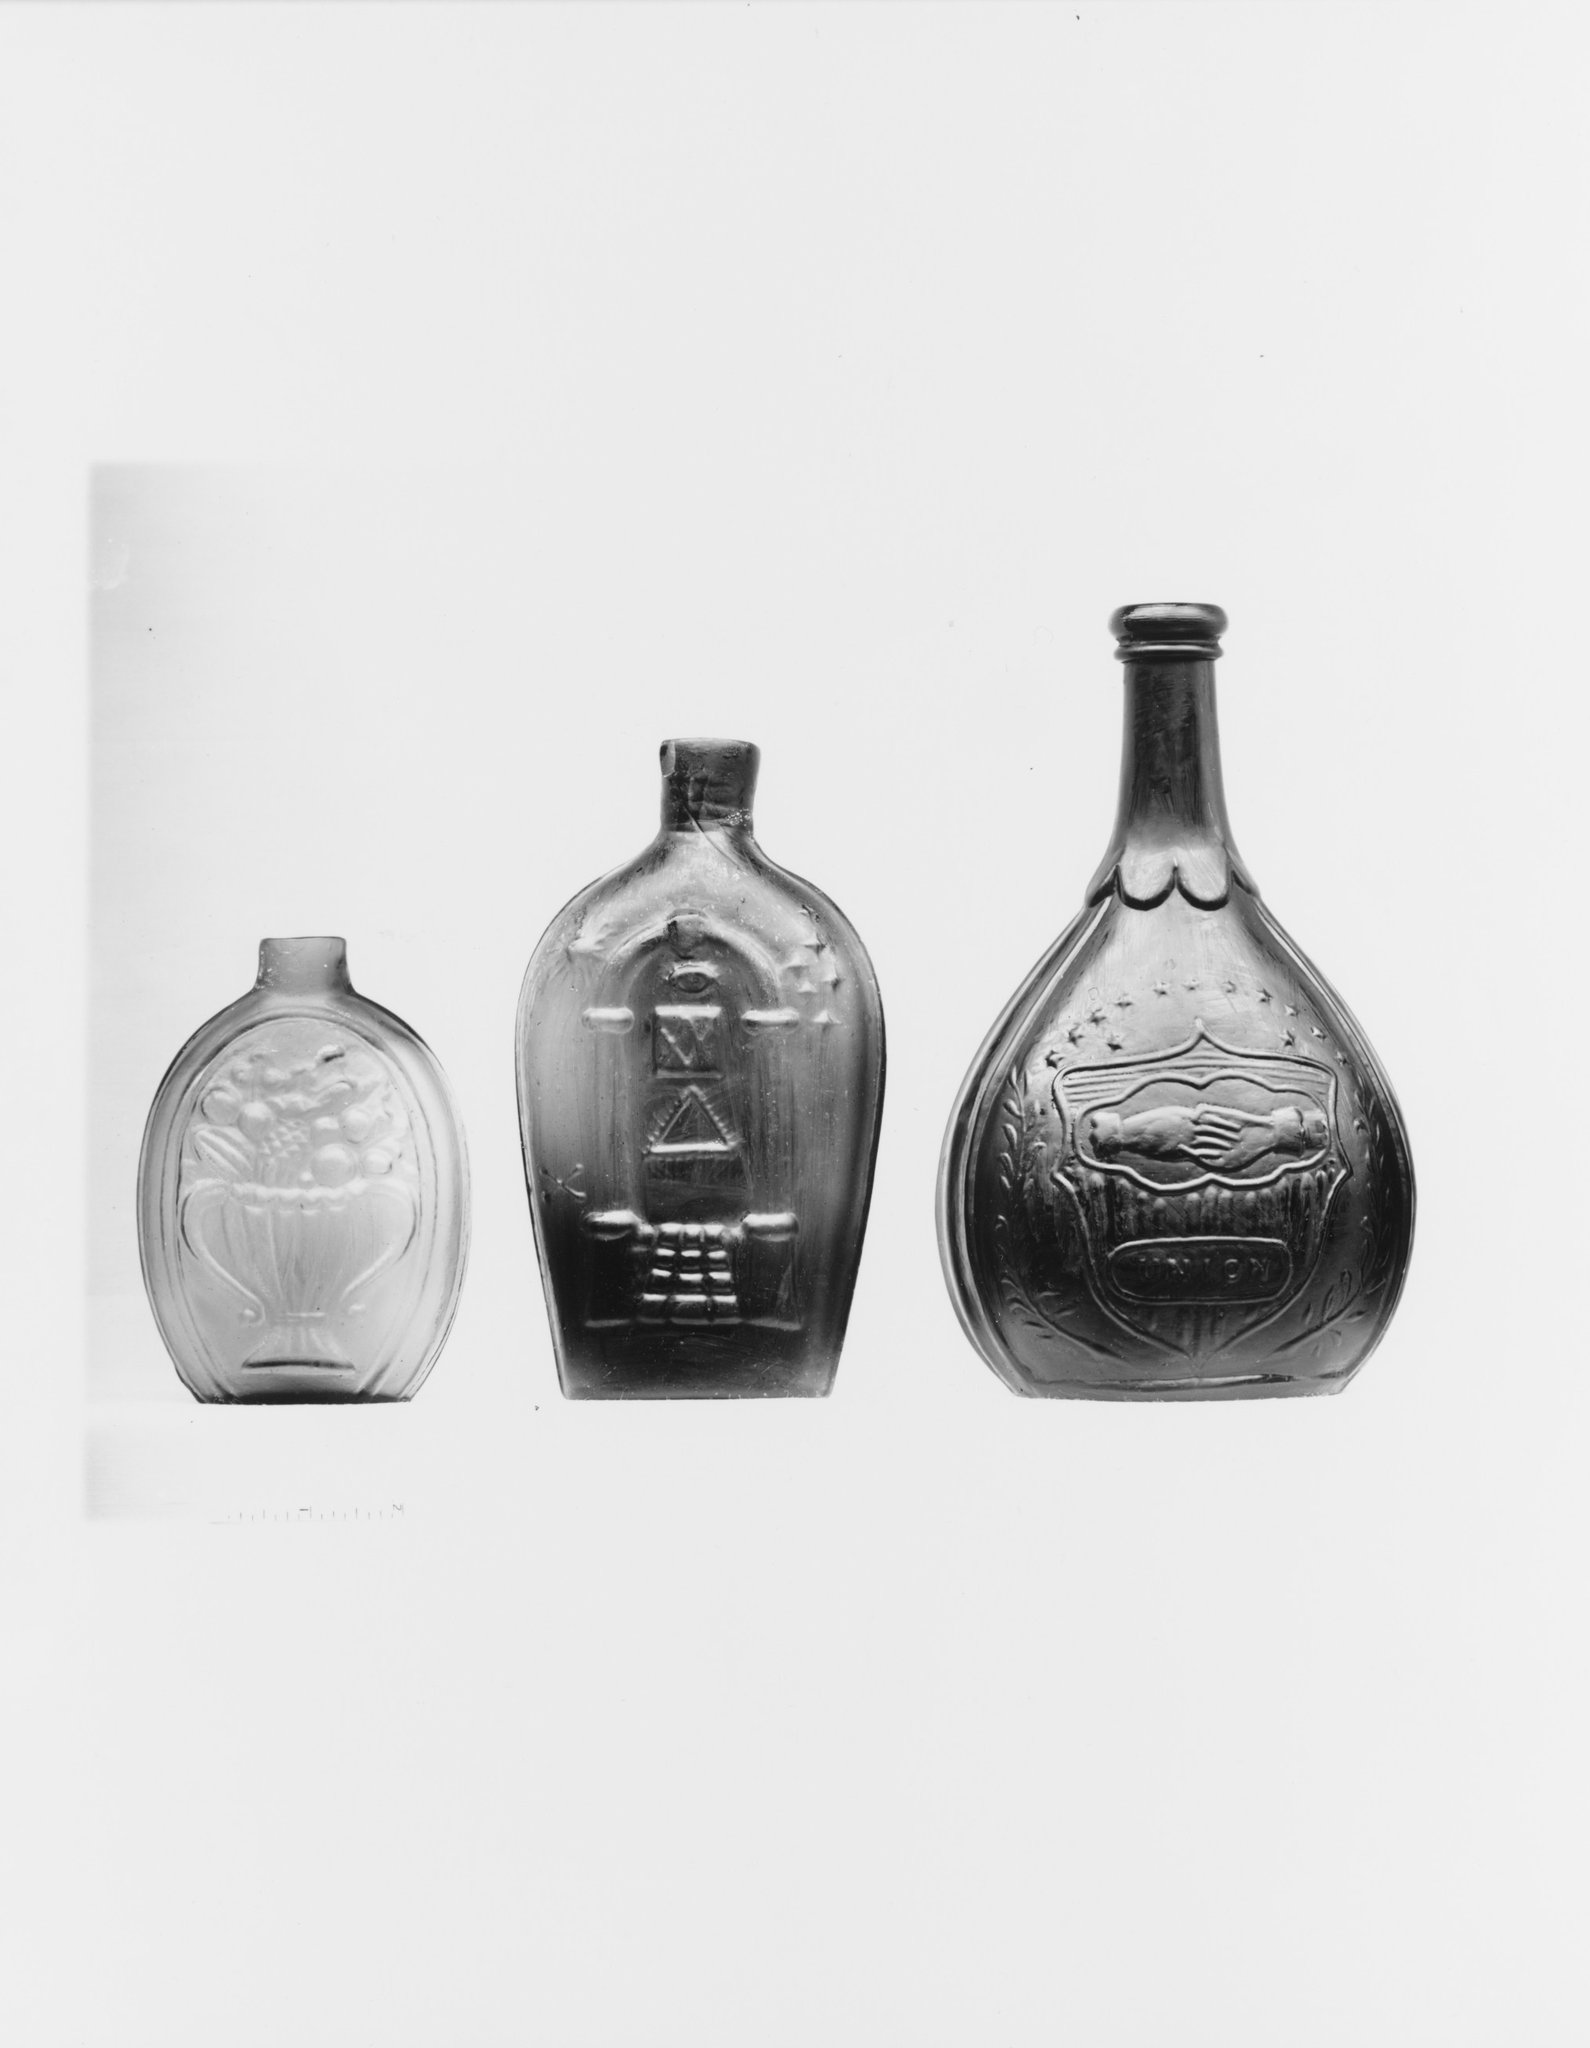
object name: flask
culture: american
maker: keene marlboro street glassworks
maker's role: maker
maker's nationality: american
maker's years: 1815-1841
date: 1820-1830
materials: glass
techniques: glassblowing, molding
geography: united states